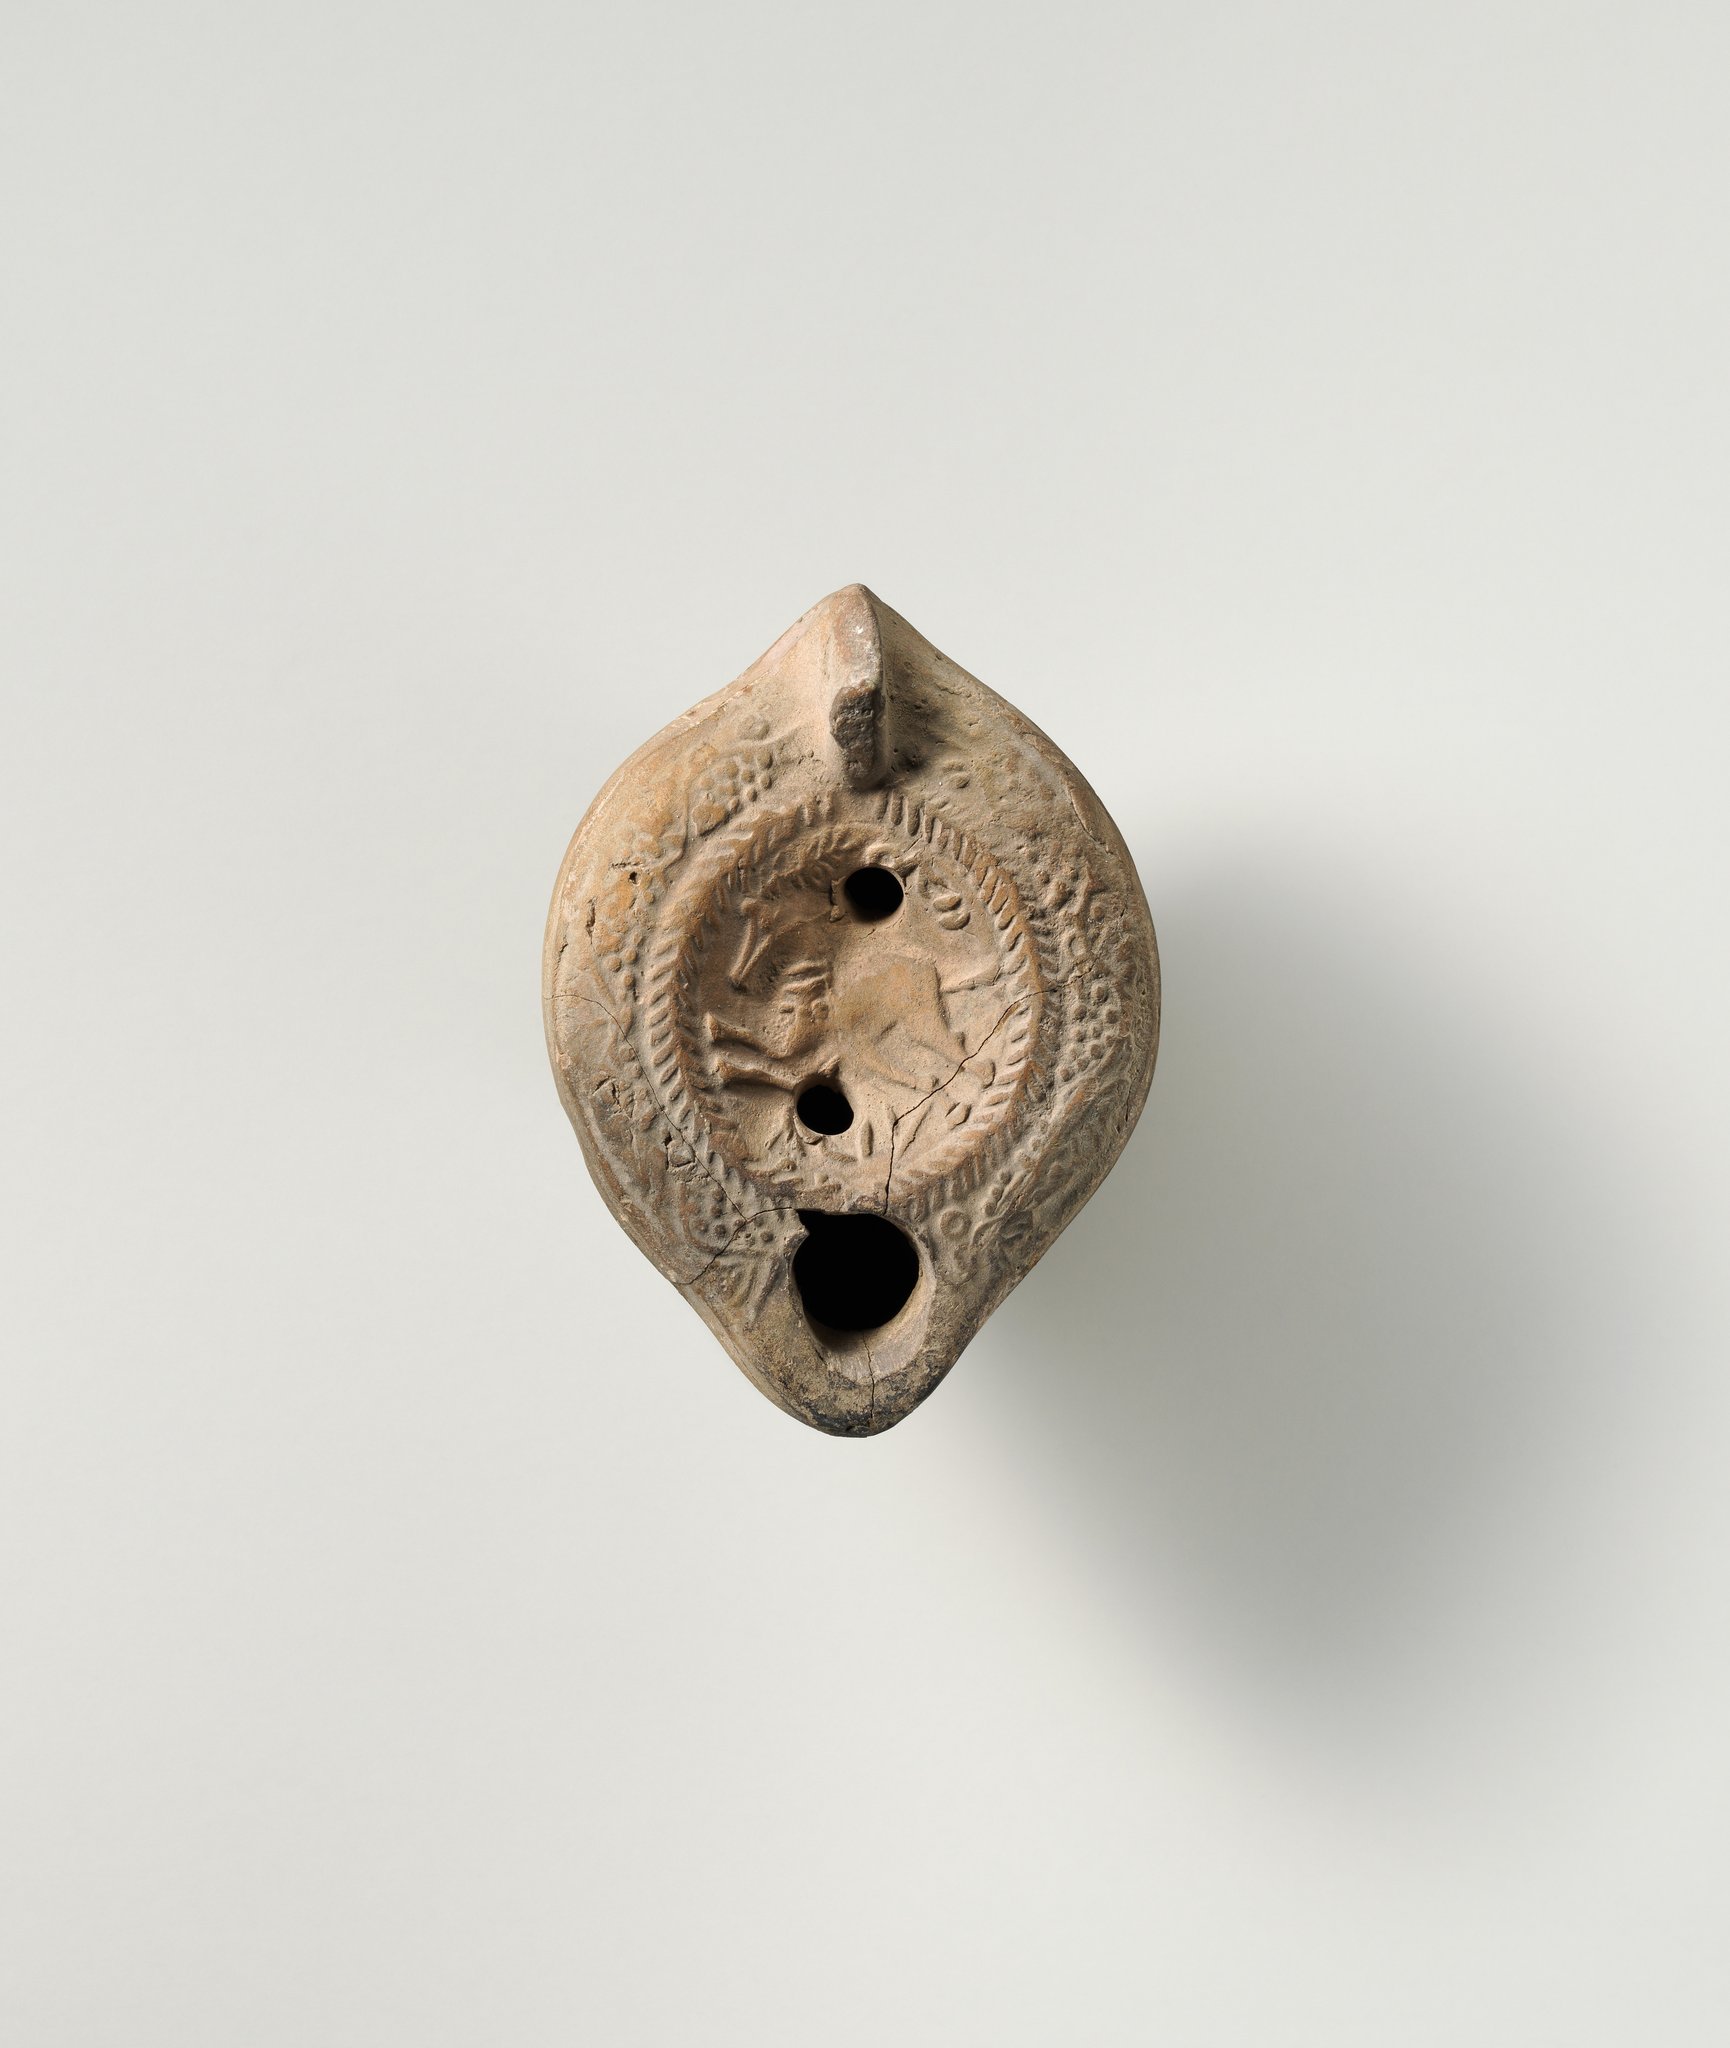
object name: lamp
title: Terracotta oil lamp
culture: roman, cypriot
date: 301-500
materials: terracotta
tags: bulls